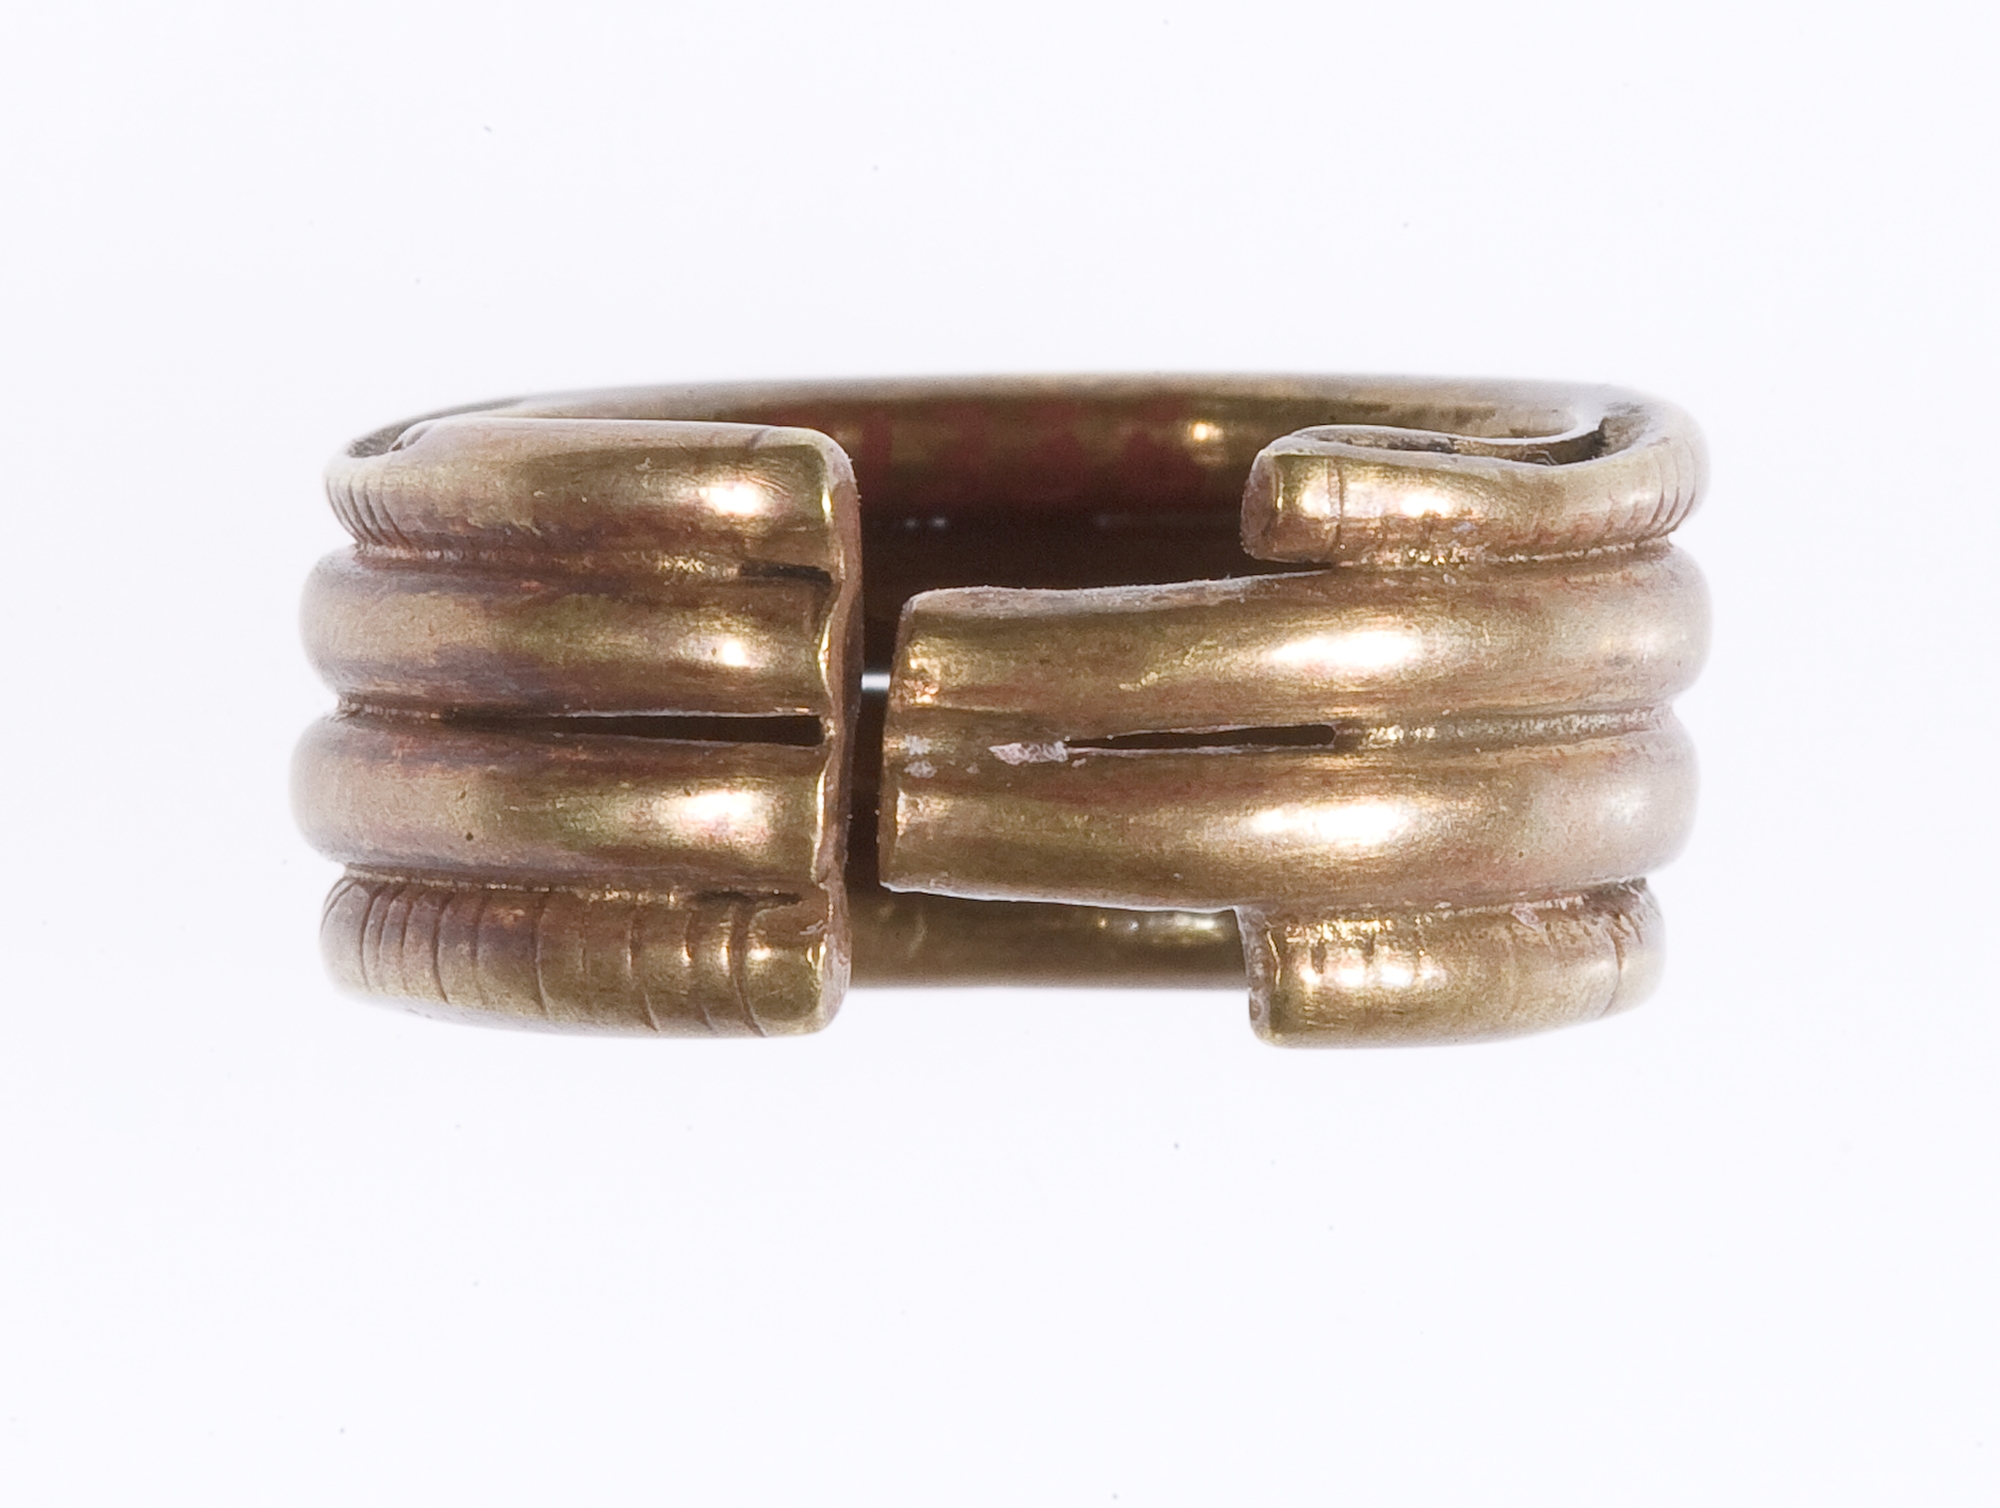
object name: earring, penannular, ribbed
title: Ribbed Penannular Earring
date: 1550-1425 BCE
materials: gold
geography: egypt